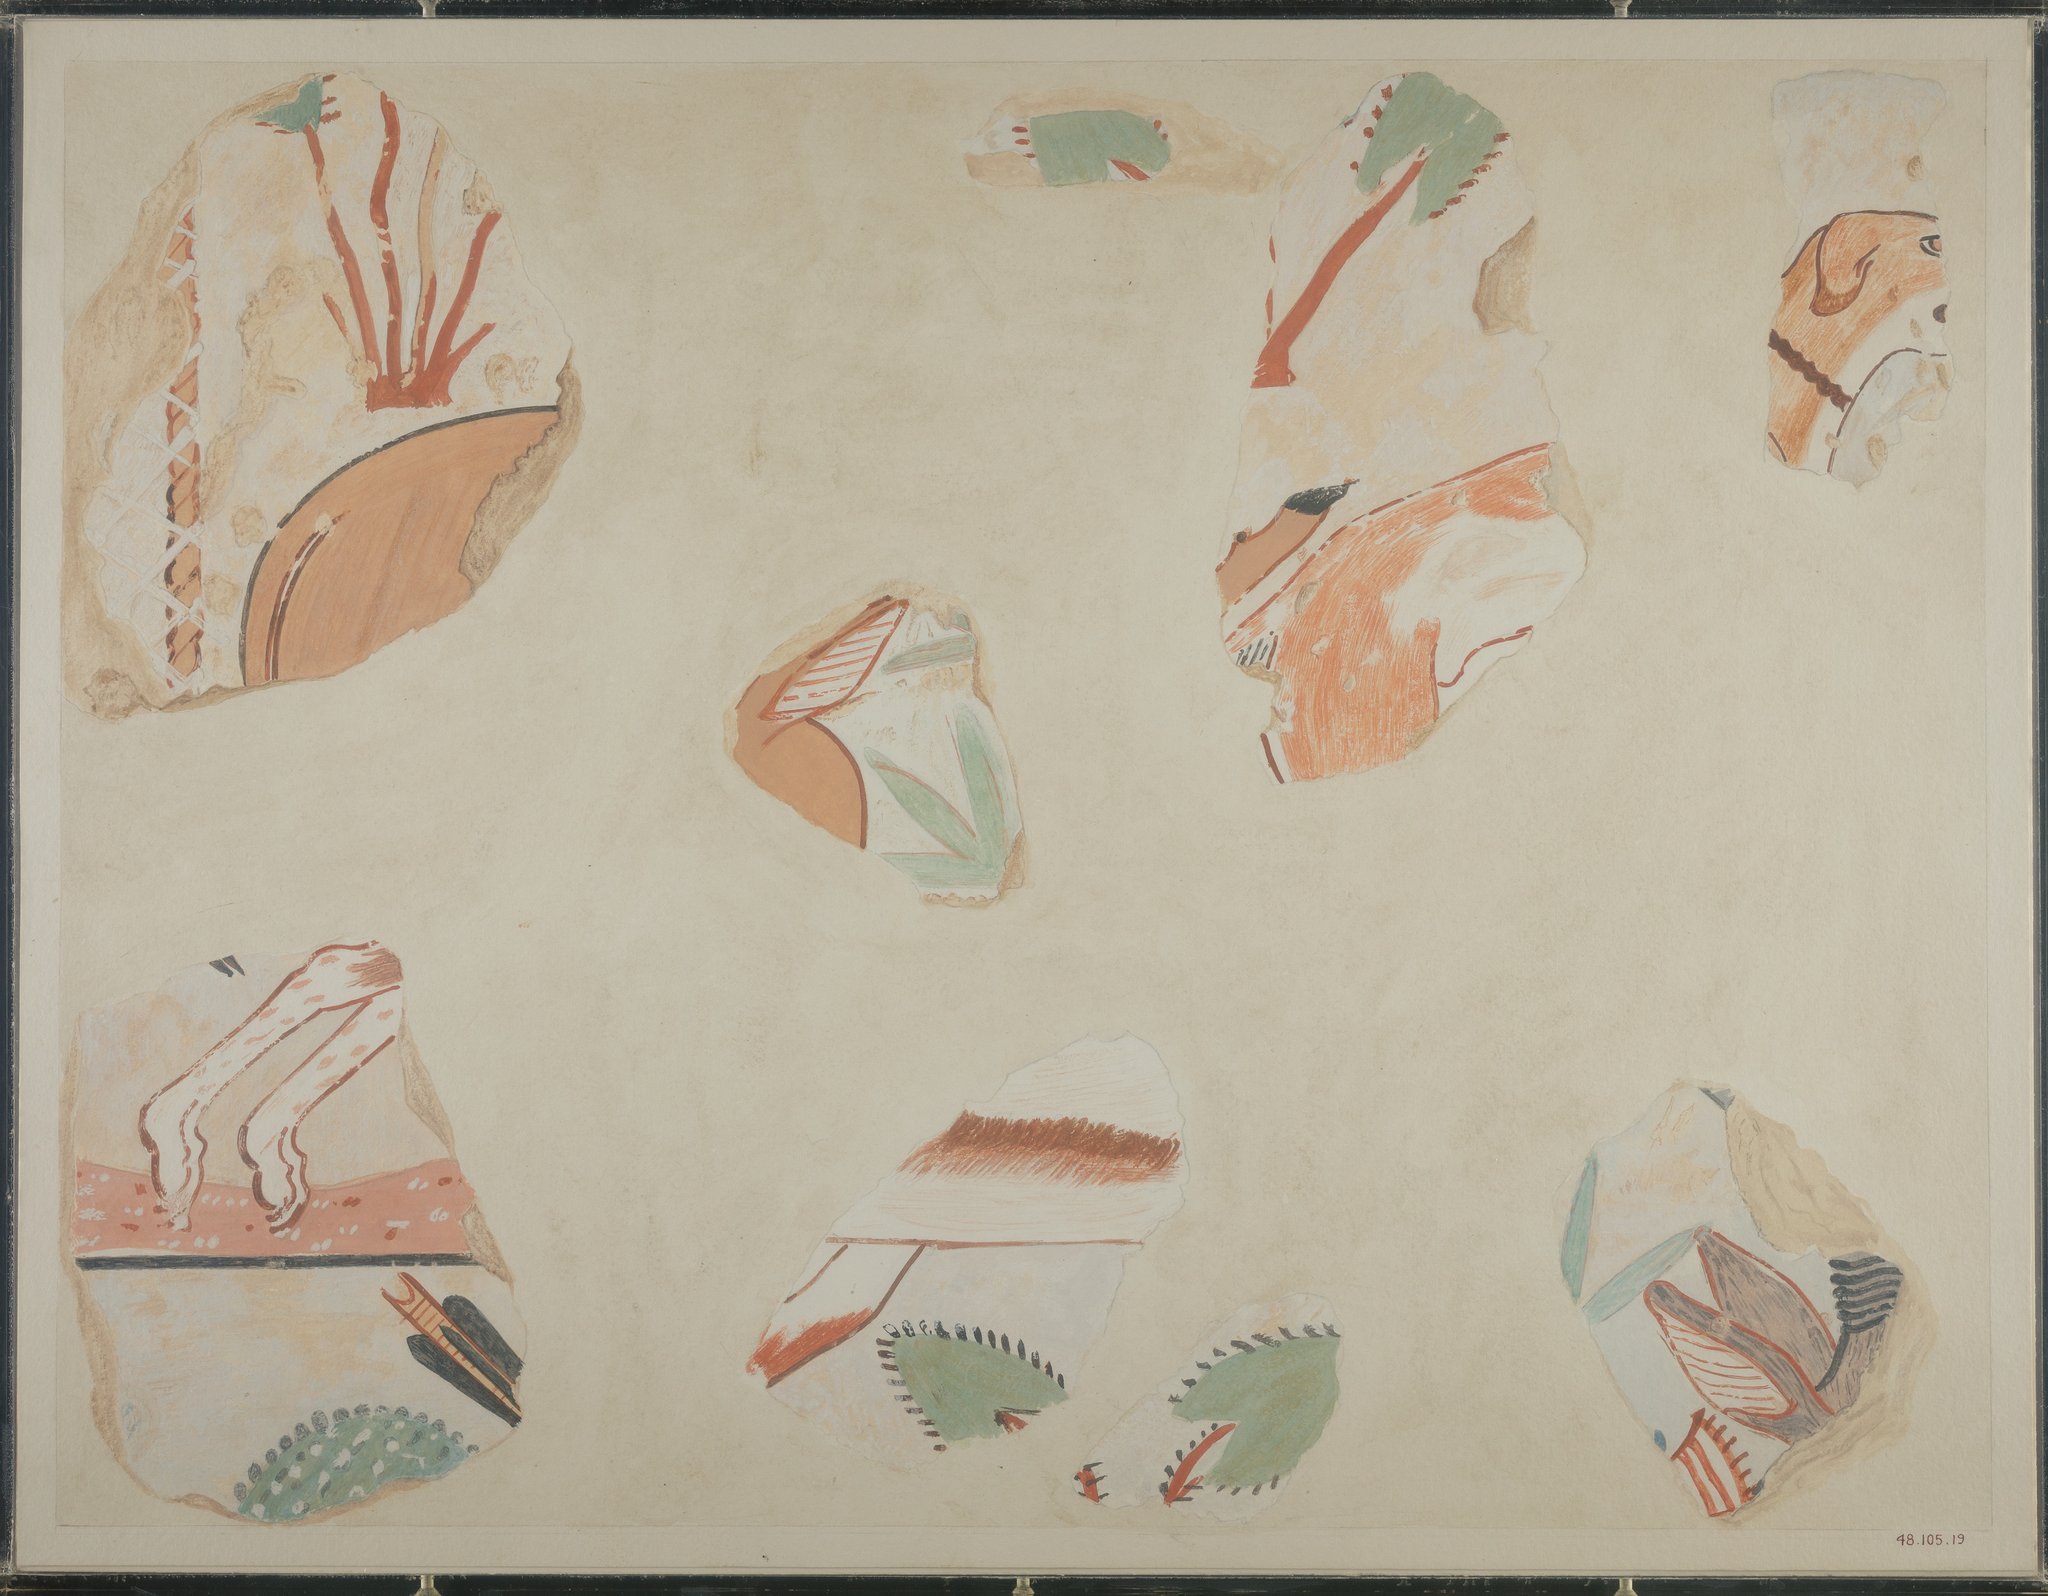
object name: facsimile, intef tt 155, hunting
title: Fragments of a Hunting Scene, Tomb of Intef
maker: unknown copyist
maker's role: artist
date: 1479-1458 BCE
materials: paper, paint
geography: egypt